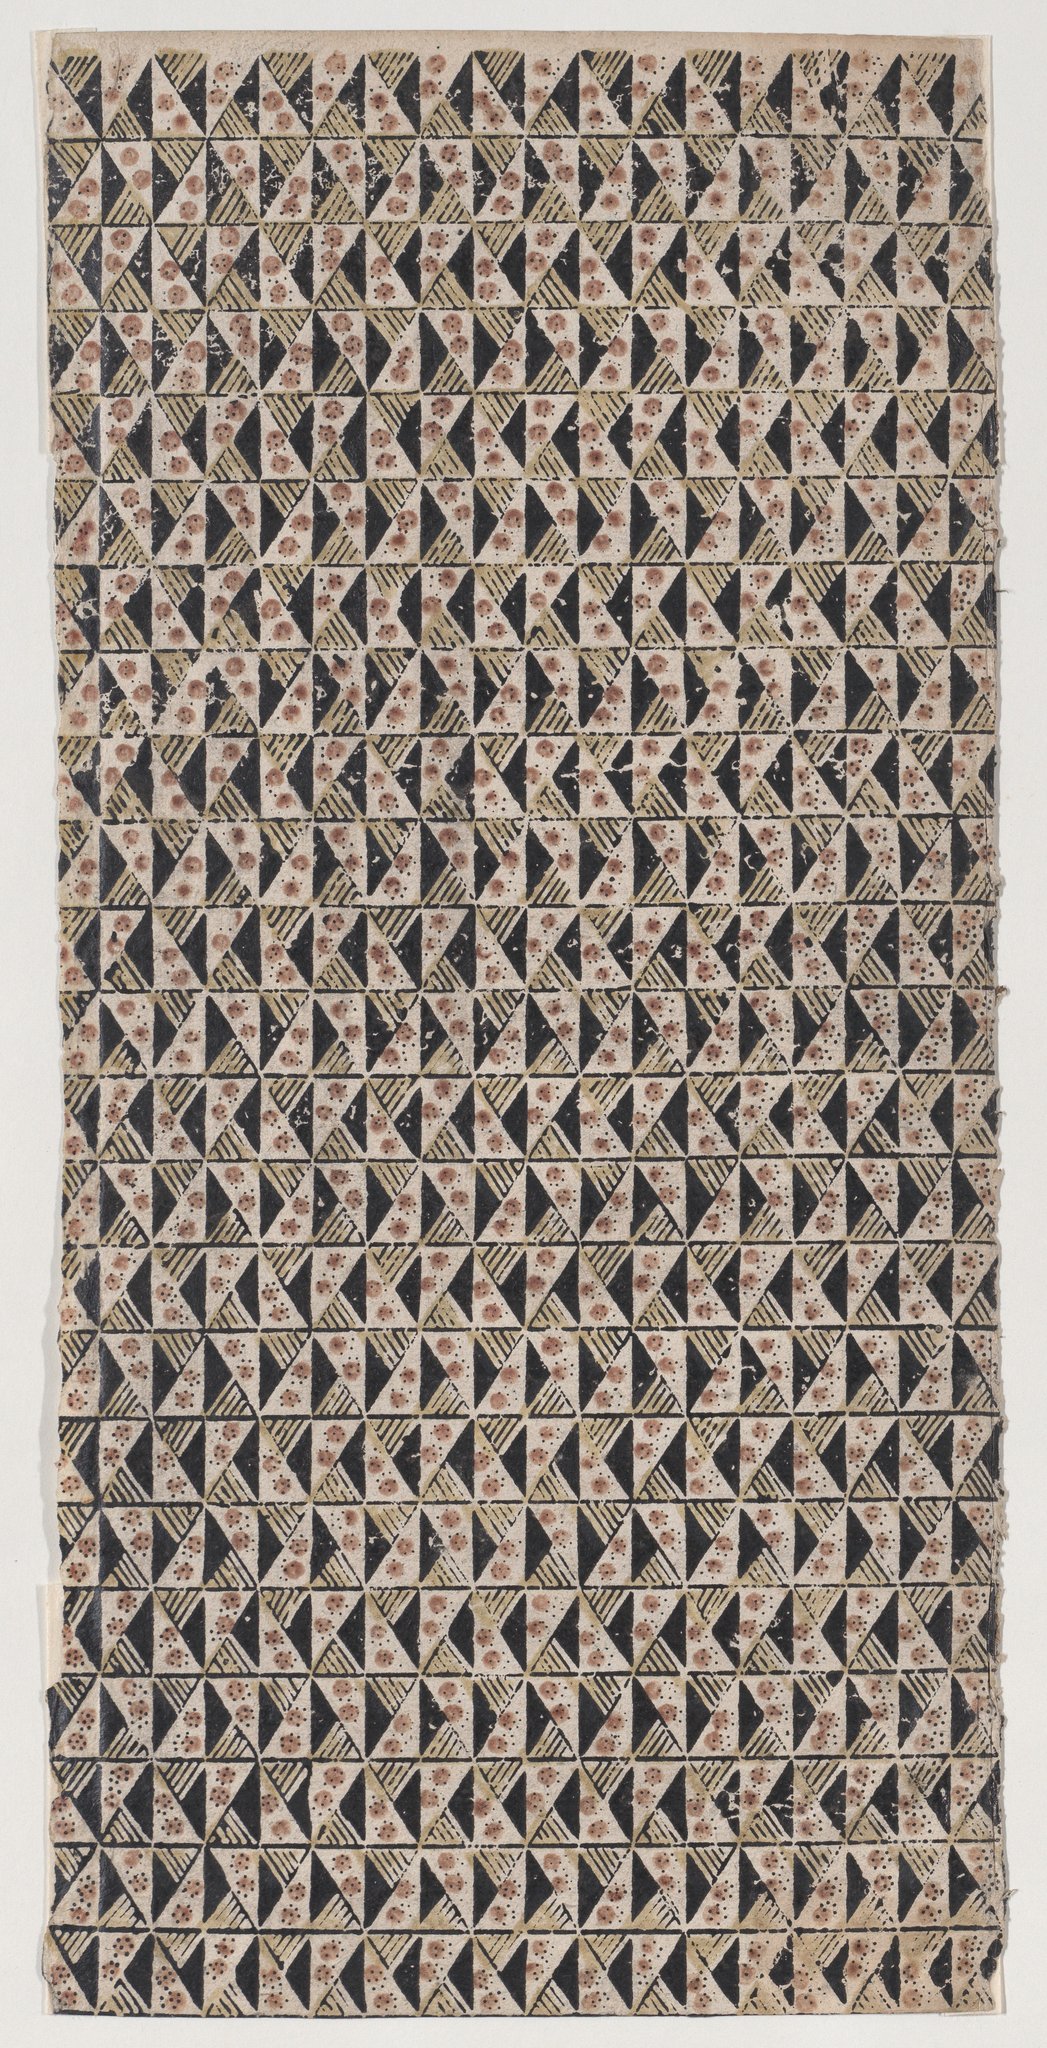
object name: print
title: Sheet with pattern of triangles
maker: Anonymous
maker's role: artist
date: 1801-1900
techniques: relief print